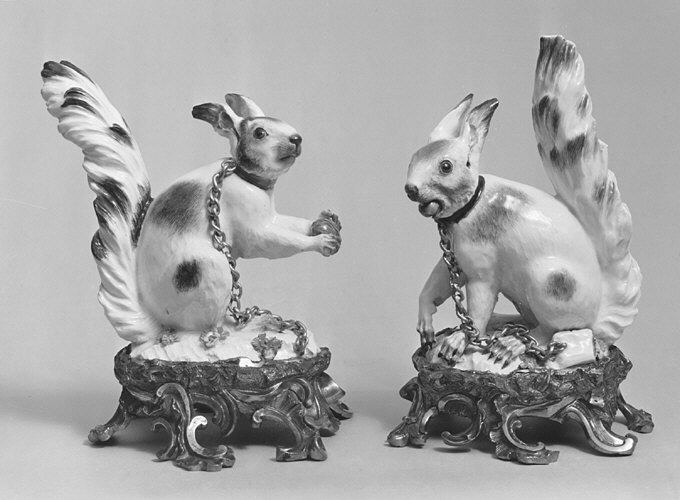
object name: figure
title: Pair of squirrels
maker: meissen manufactory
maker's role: manufactory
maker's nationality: german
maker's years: 1710-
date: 1732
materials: gilt bronze, hard paste porcelain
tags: squirrels